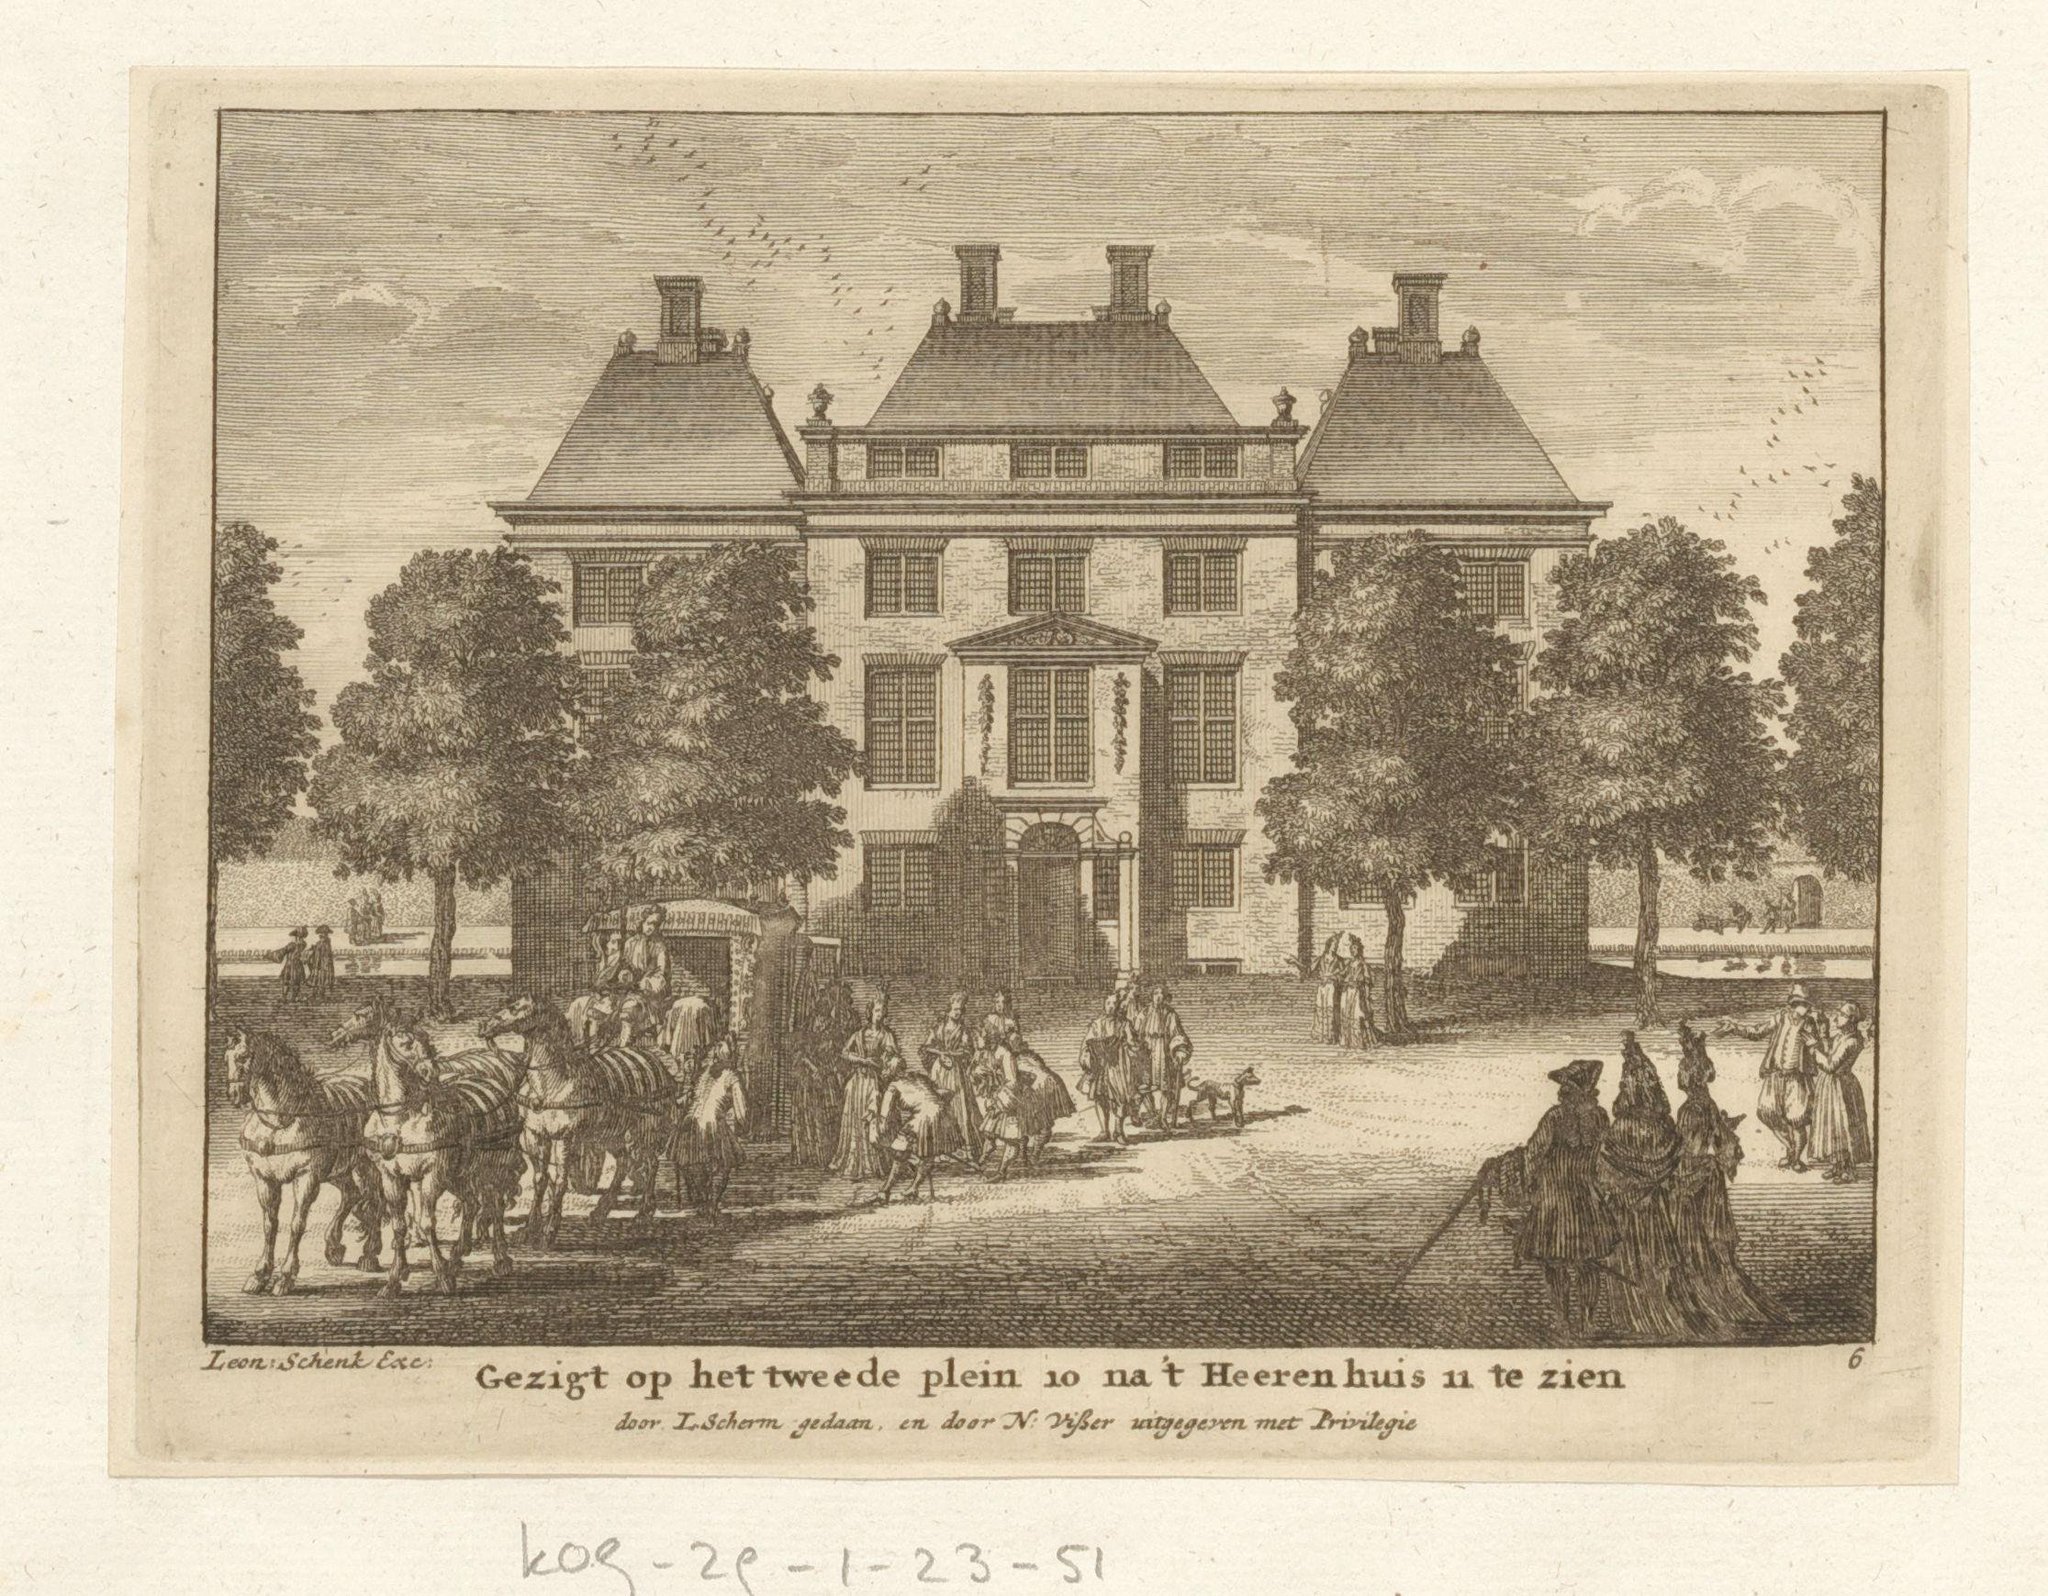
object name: print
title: Verscheyde schoone en vermaakelyke gezigten, in de Hofstede van Clingendaal gelegen by 's Gravenhage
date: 1706-1767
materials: paper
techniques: engraving, etching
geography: amsterdam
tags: exterior ~ representation of a building, country-house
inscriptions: collector's mark: Lugt 1641, stamp, stamp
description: Huis Clingendael bij Den Haag met op het plein voor het huis een koets en een elegant gezelschap. Onderwerpsrubrieken binnen de Atlas Zeden en Gewoonten: Zeden en Gewoonten in Engeren Zin, De Woning. Kastelen en buitenplaatsen. Holland.